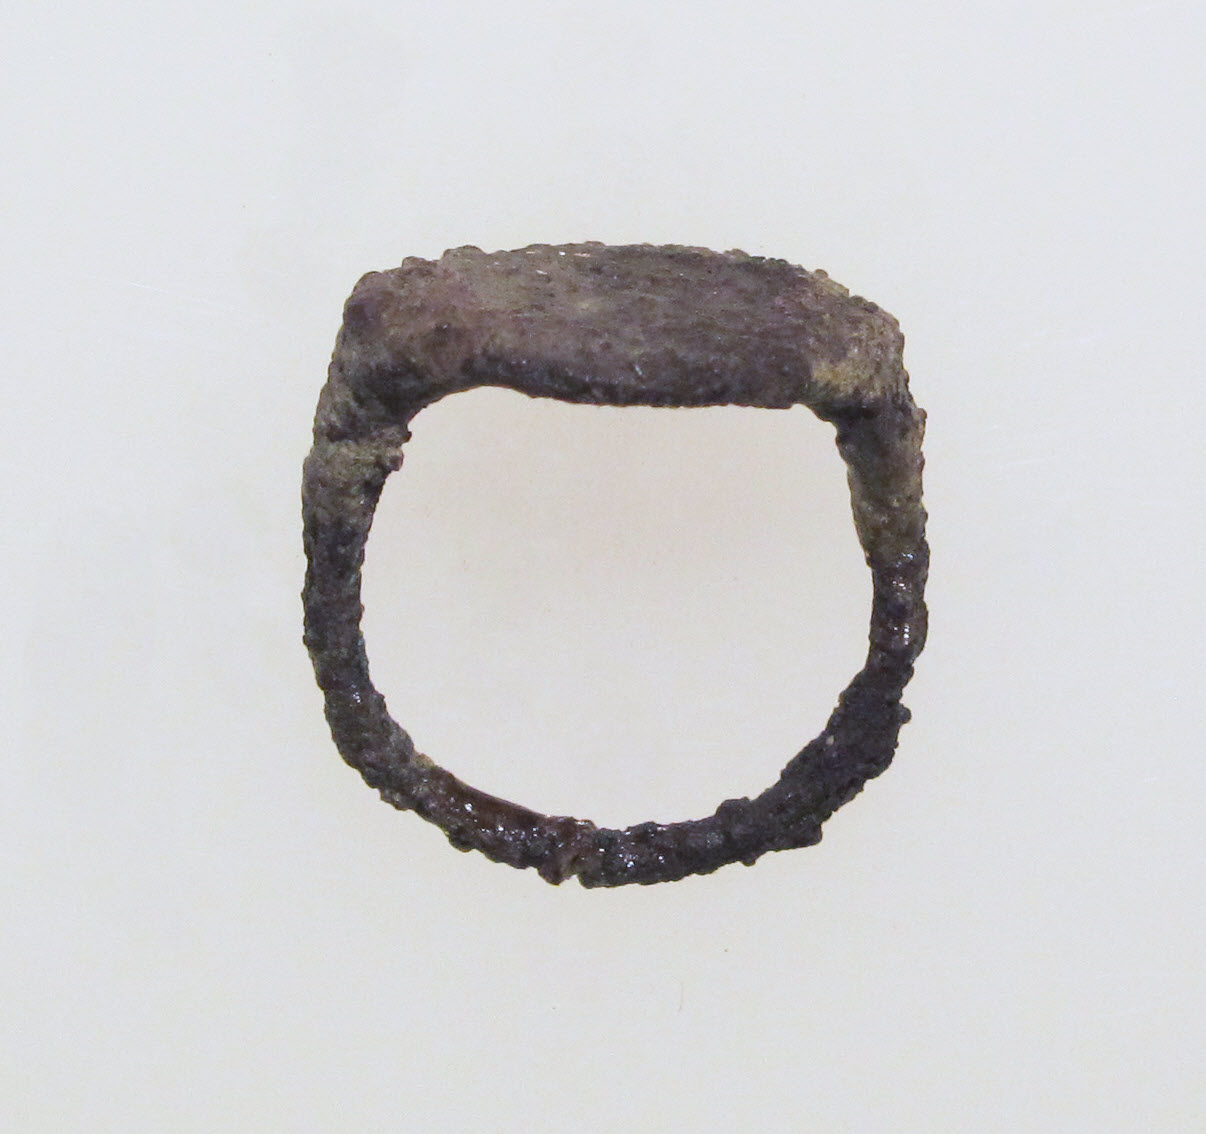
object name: ring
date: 7000 BCE-330 CE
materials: silver